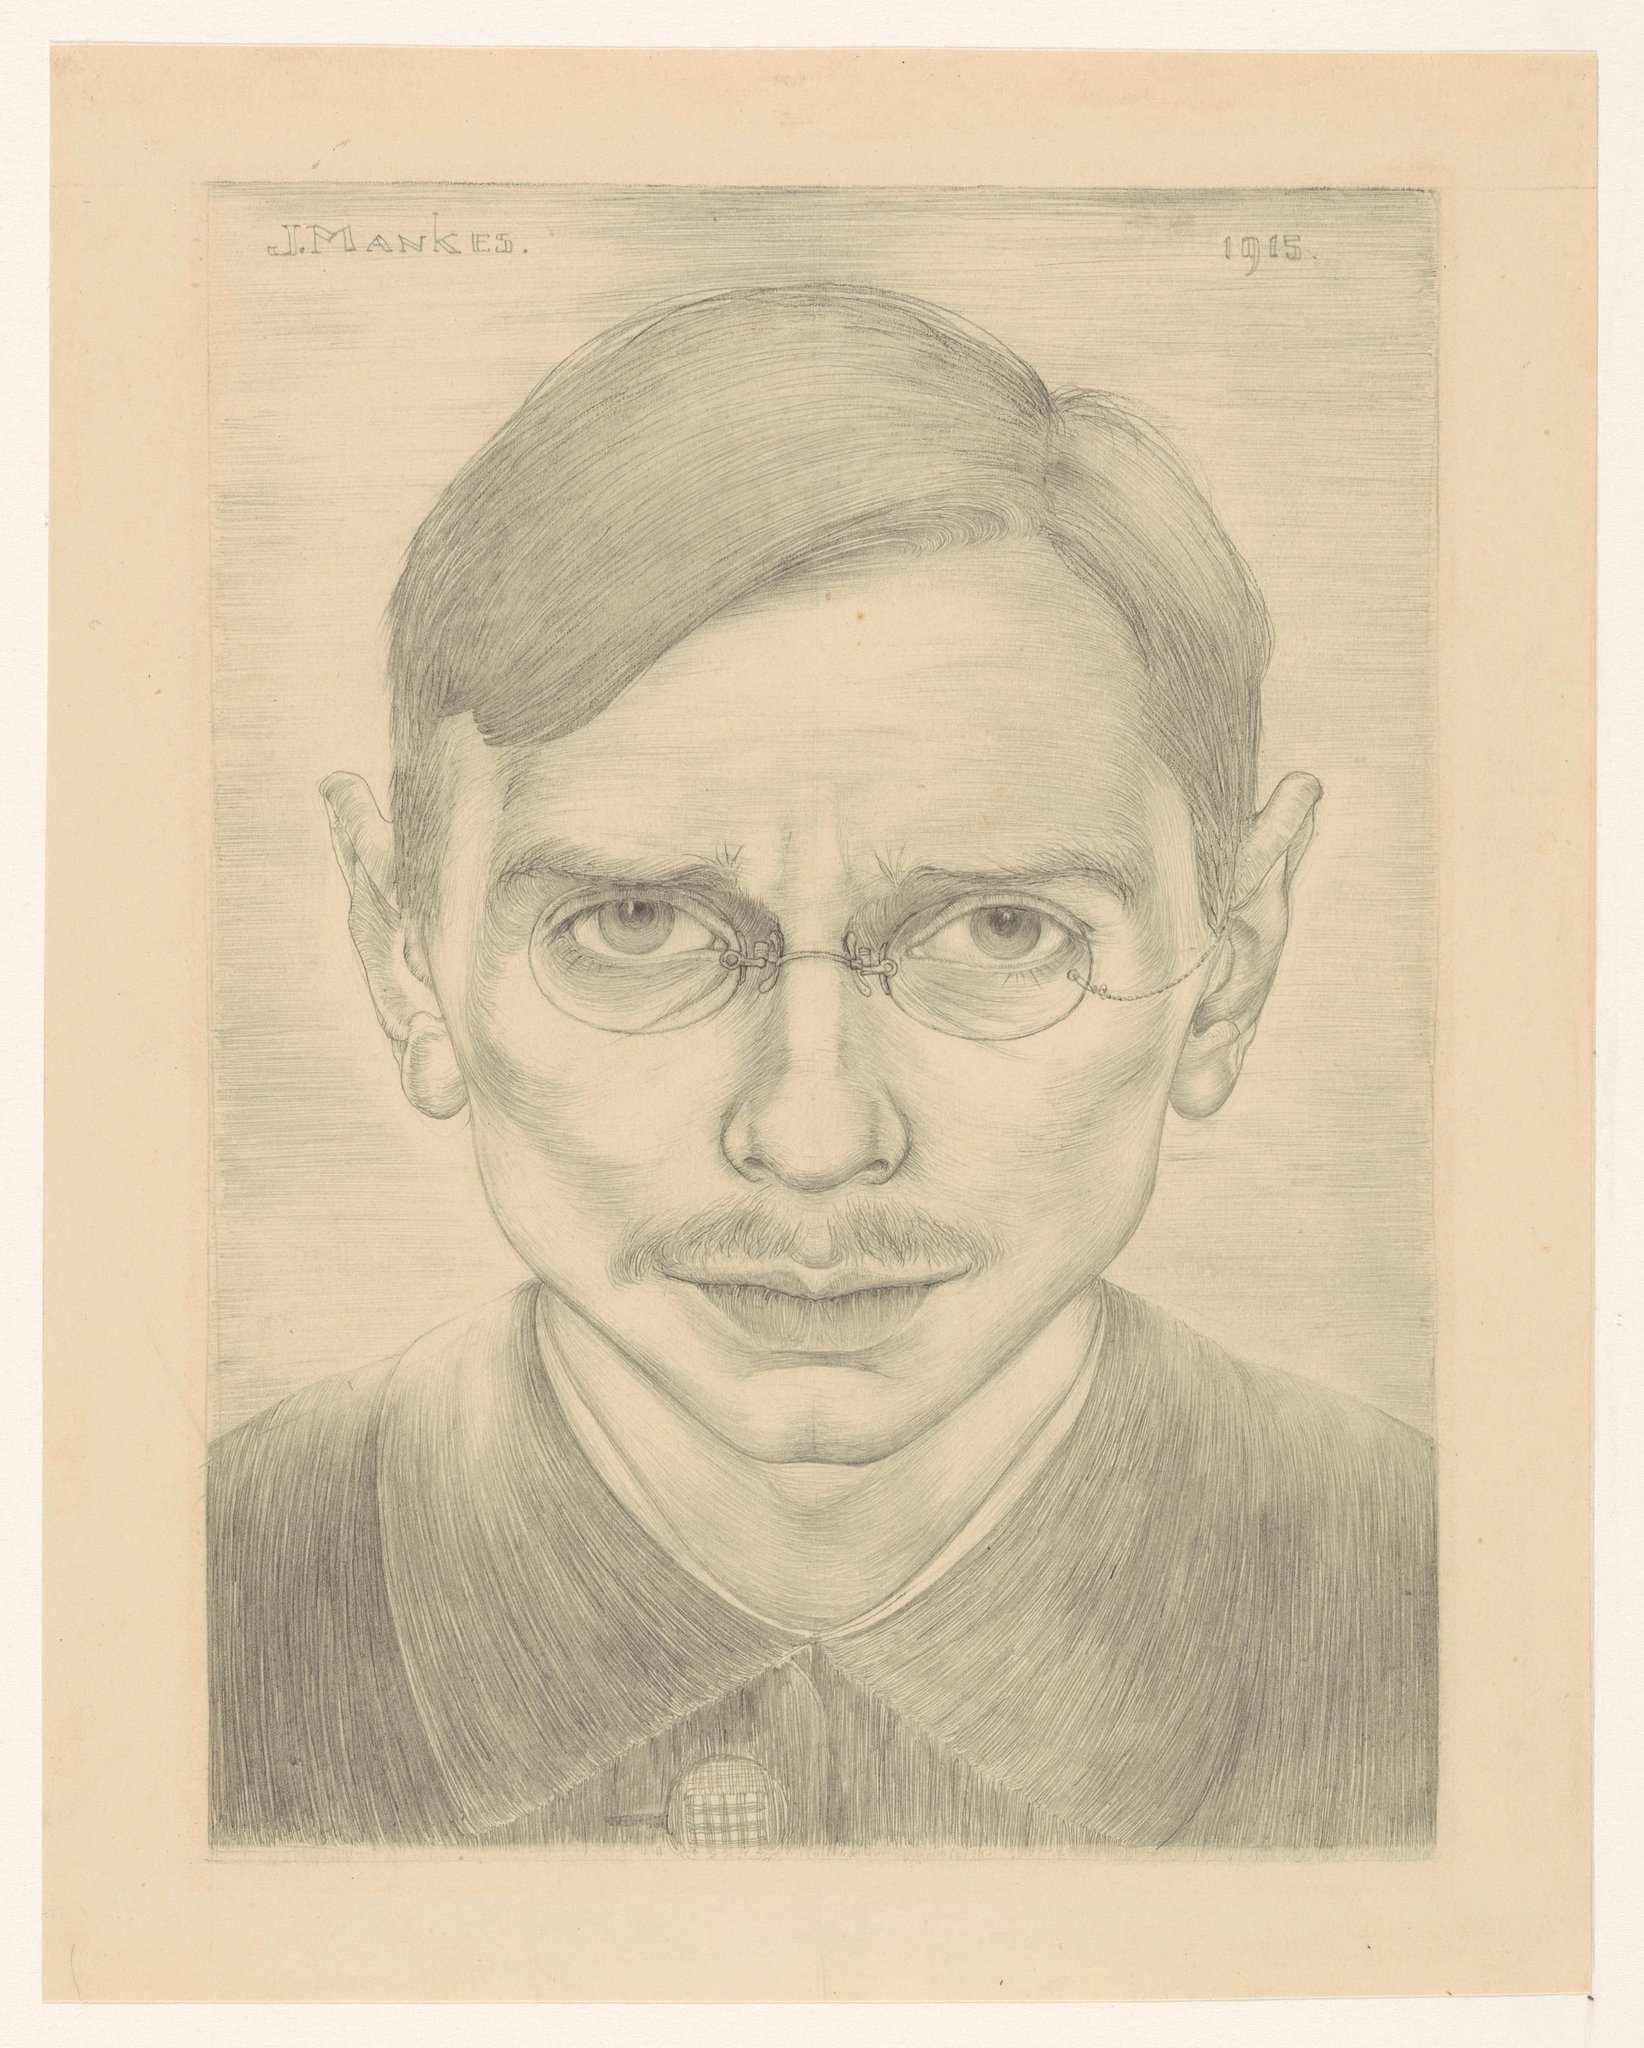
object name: drawing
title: Zelfportret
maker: jan mankes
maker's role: draughtsman, painter, print maker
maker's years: 1889-1920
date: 1915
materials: chalk, paper, pencil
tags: print maker, jan mankes, historical persons, portrait, self-portrait of artist, portrait, self-portrait of draughtsman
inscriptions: date